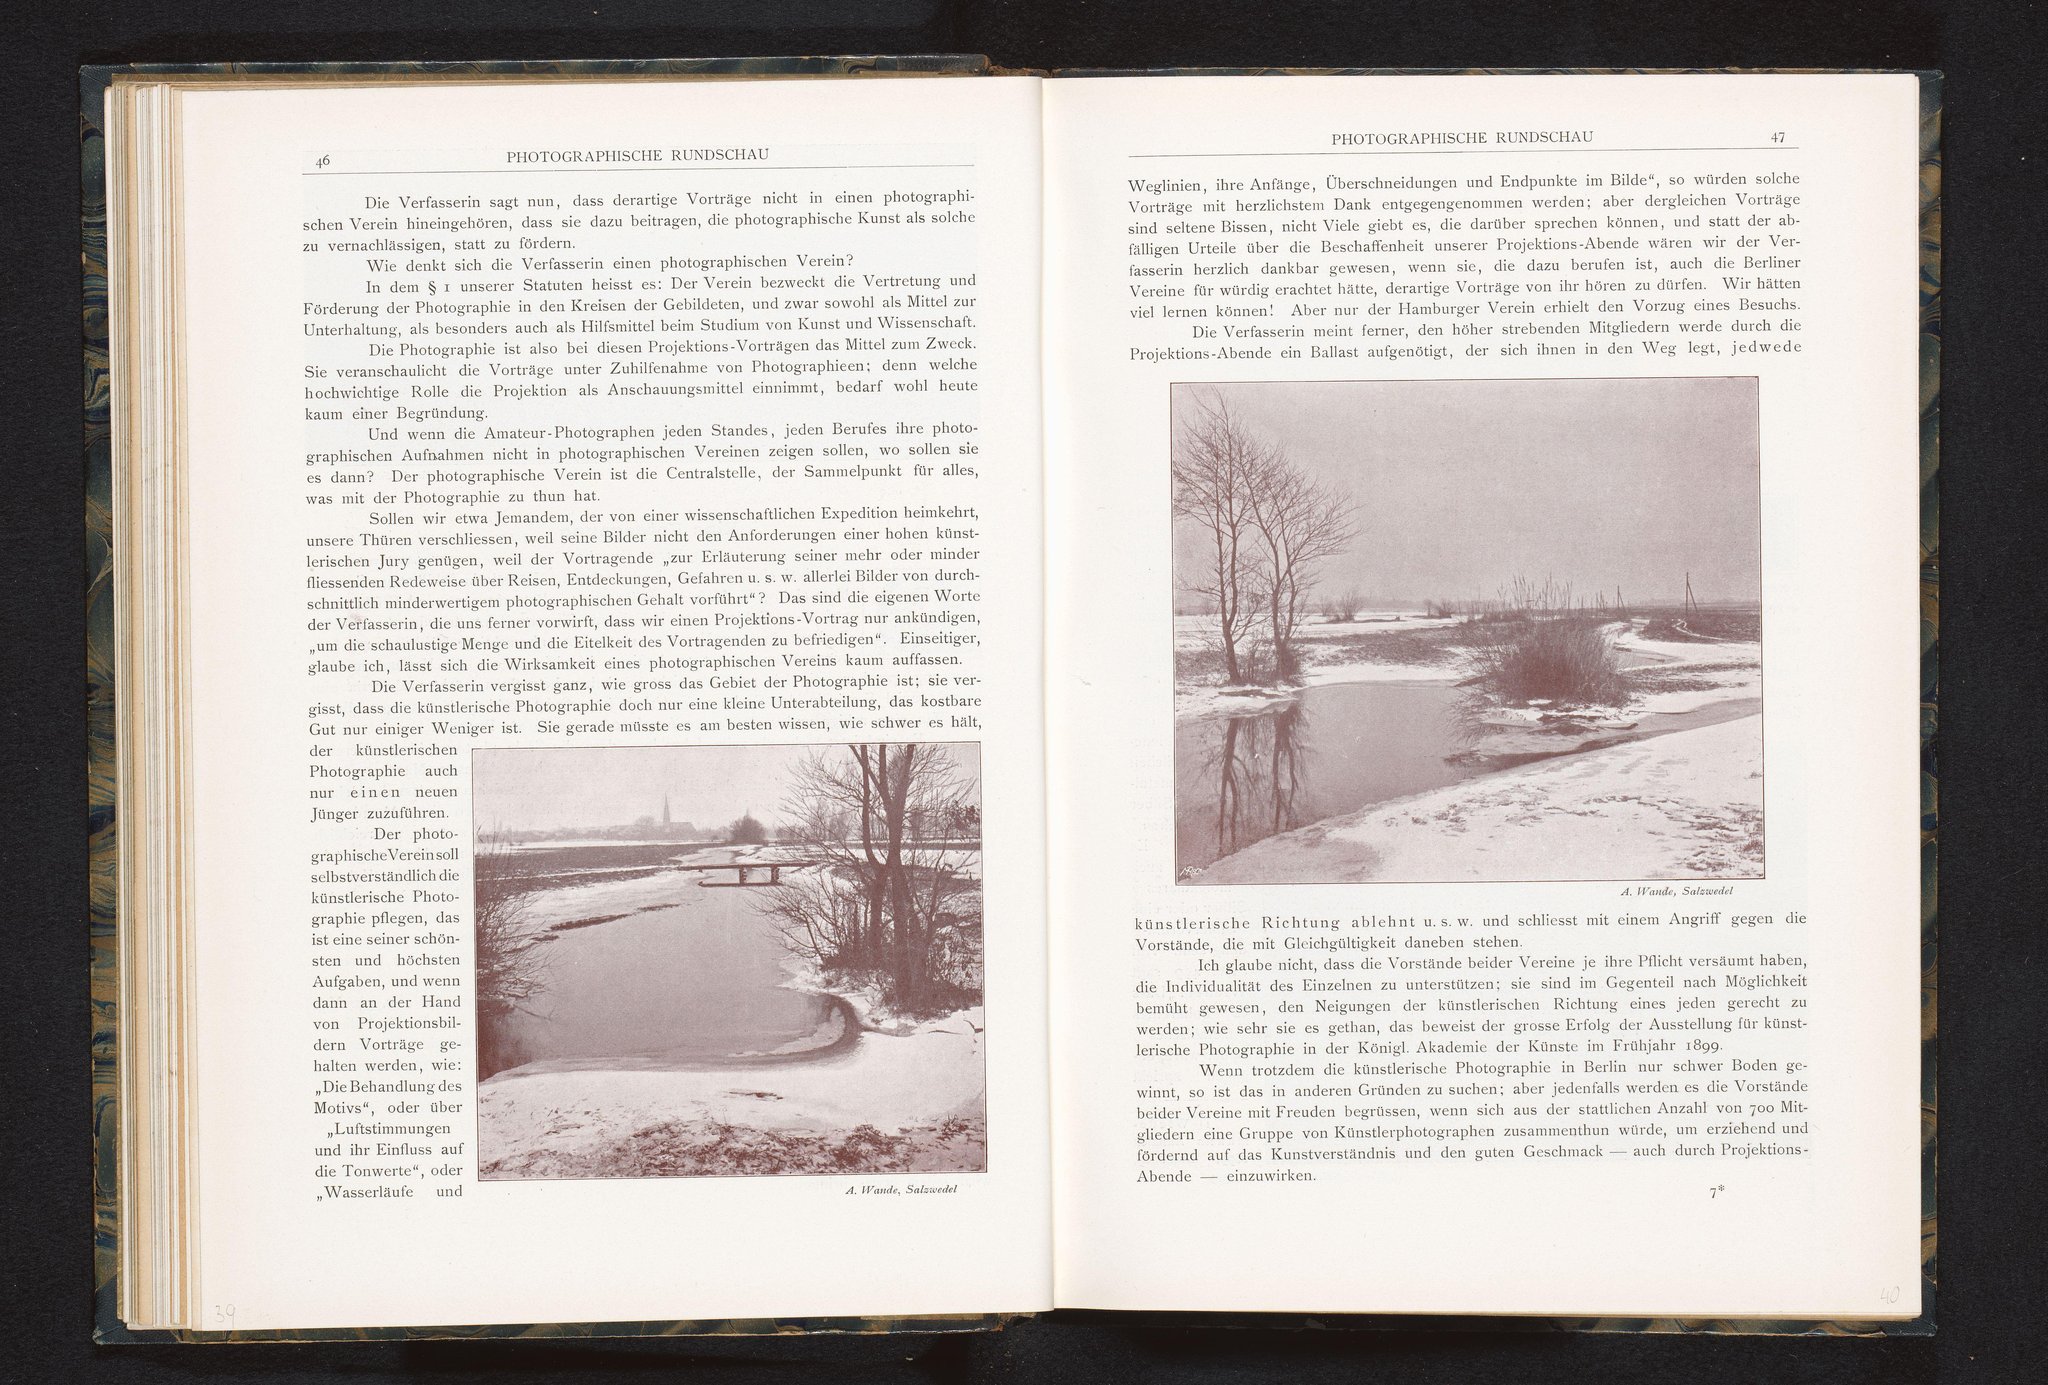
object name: page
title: Gezicht op een winters landschap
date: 1895-1900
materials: paper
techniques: autotype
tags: landscapes, snow